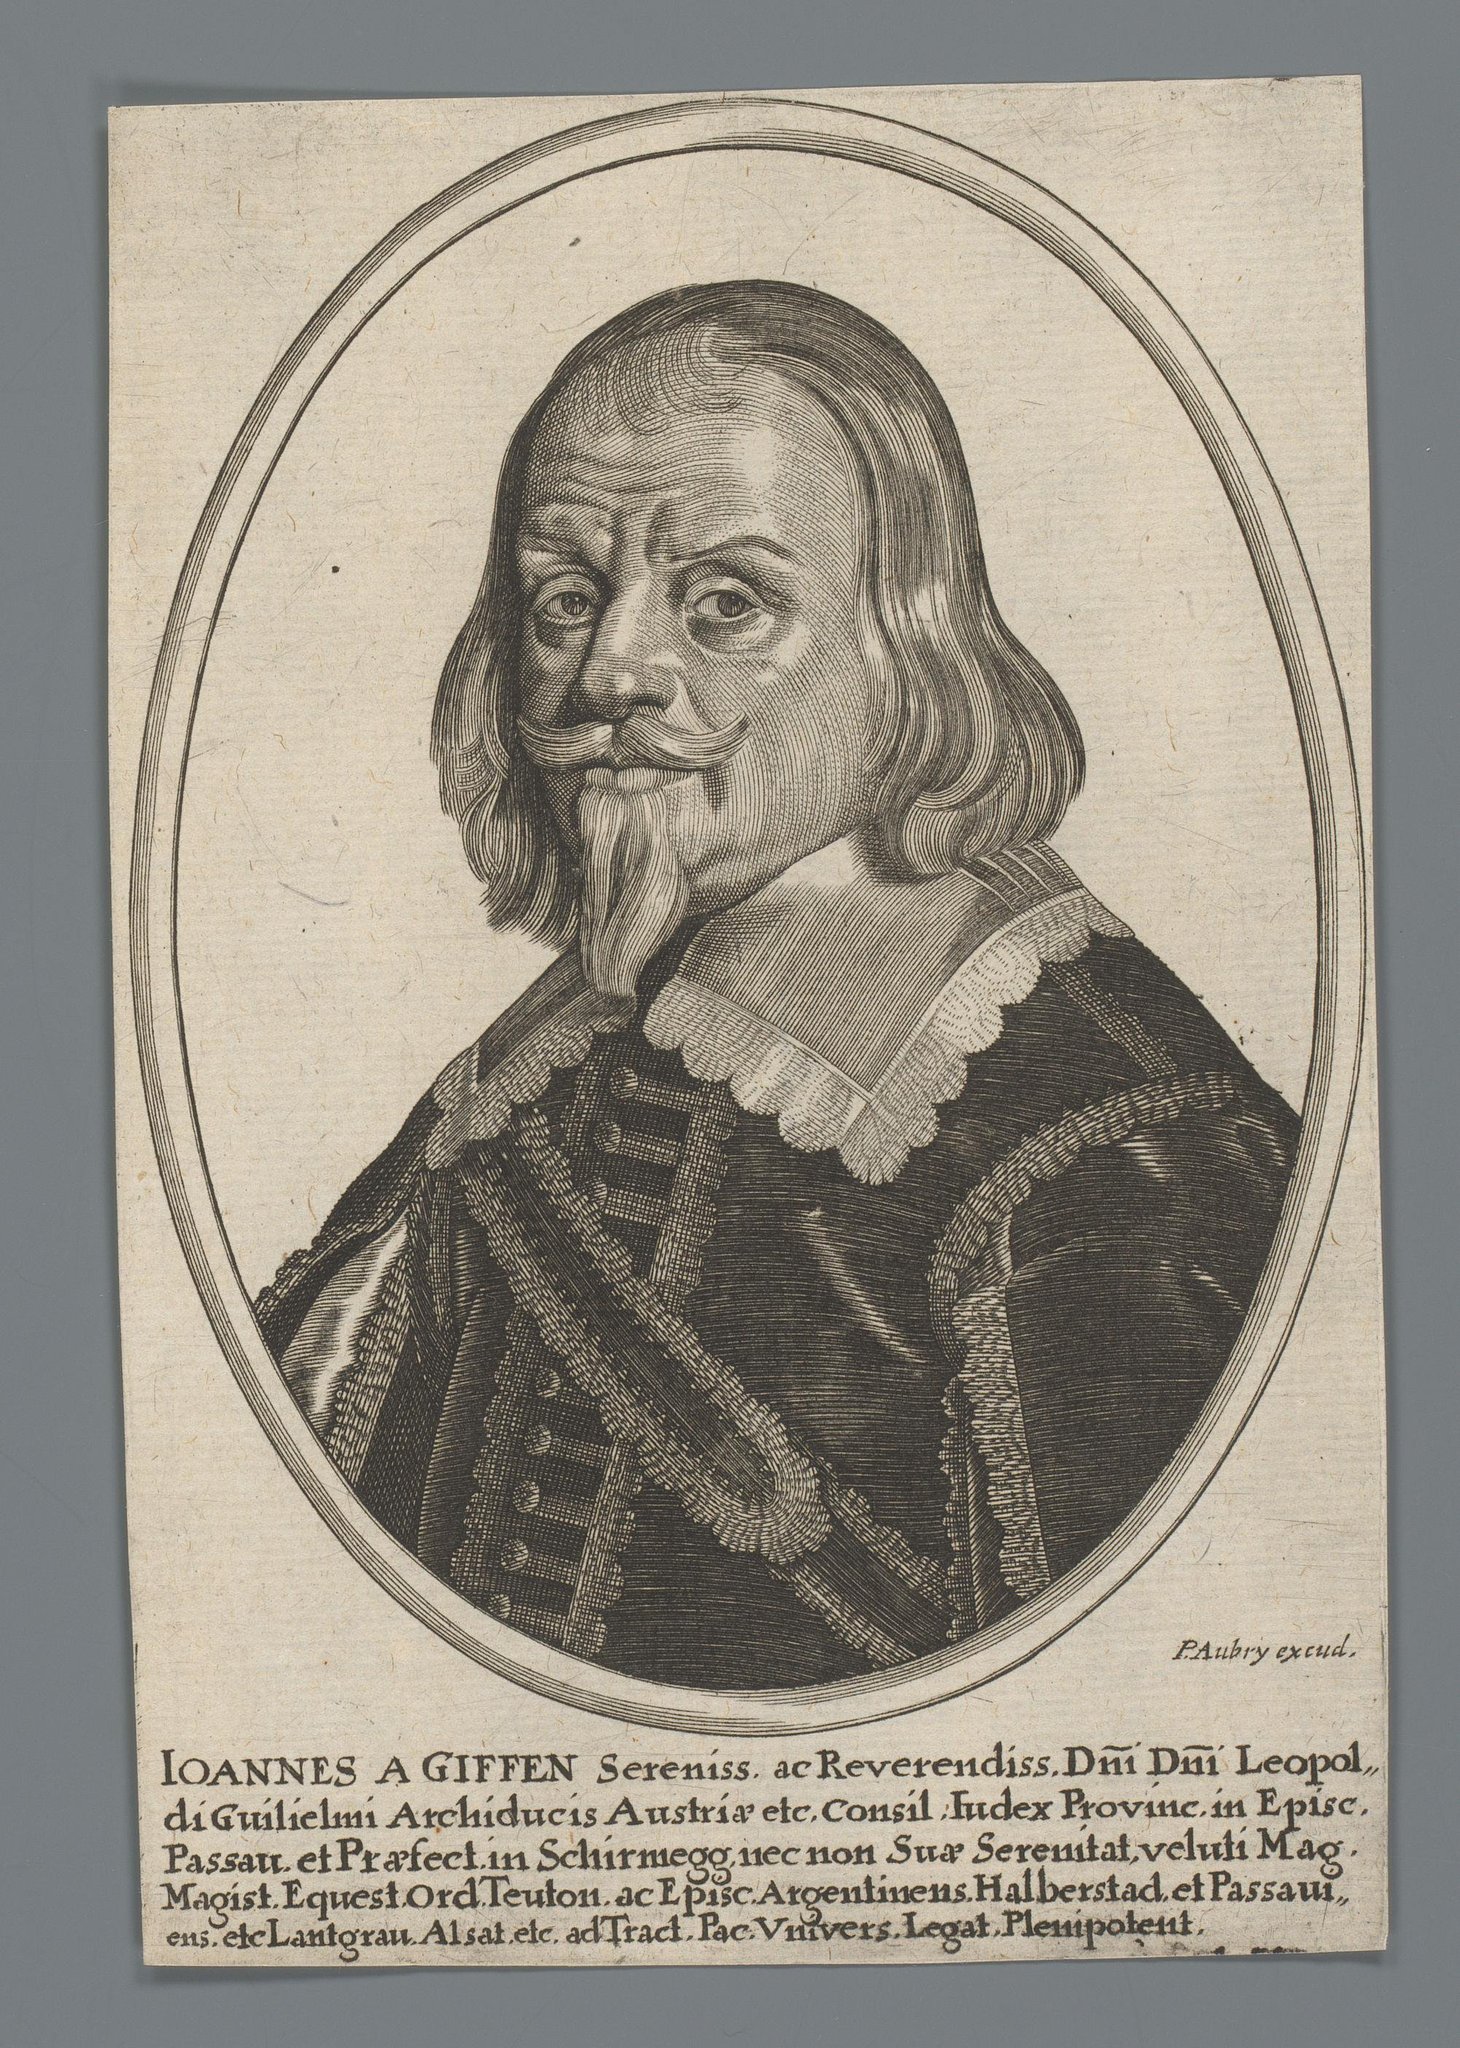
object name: print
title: Portretten van afgevaardigden bij de Vrede van Westfalen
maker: Anonymous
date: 1648-1650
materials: paper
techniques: engraving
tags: historical persons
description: Met vijfregelig onderschrift in het Latijn.